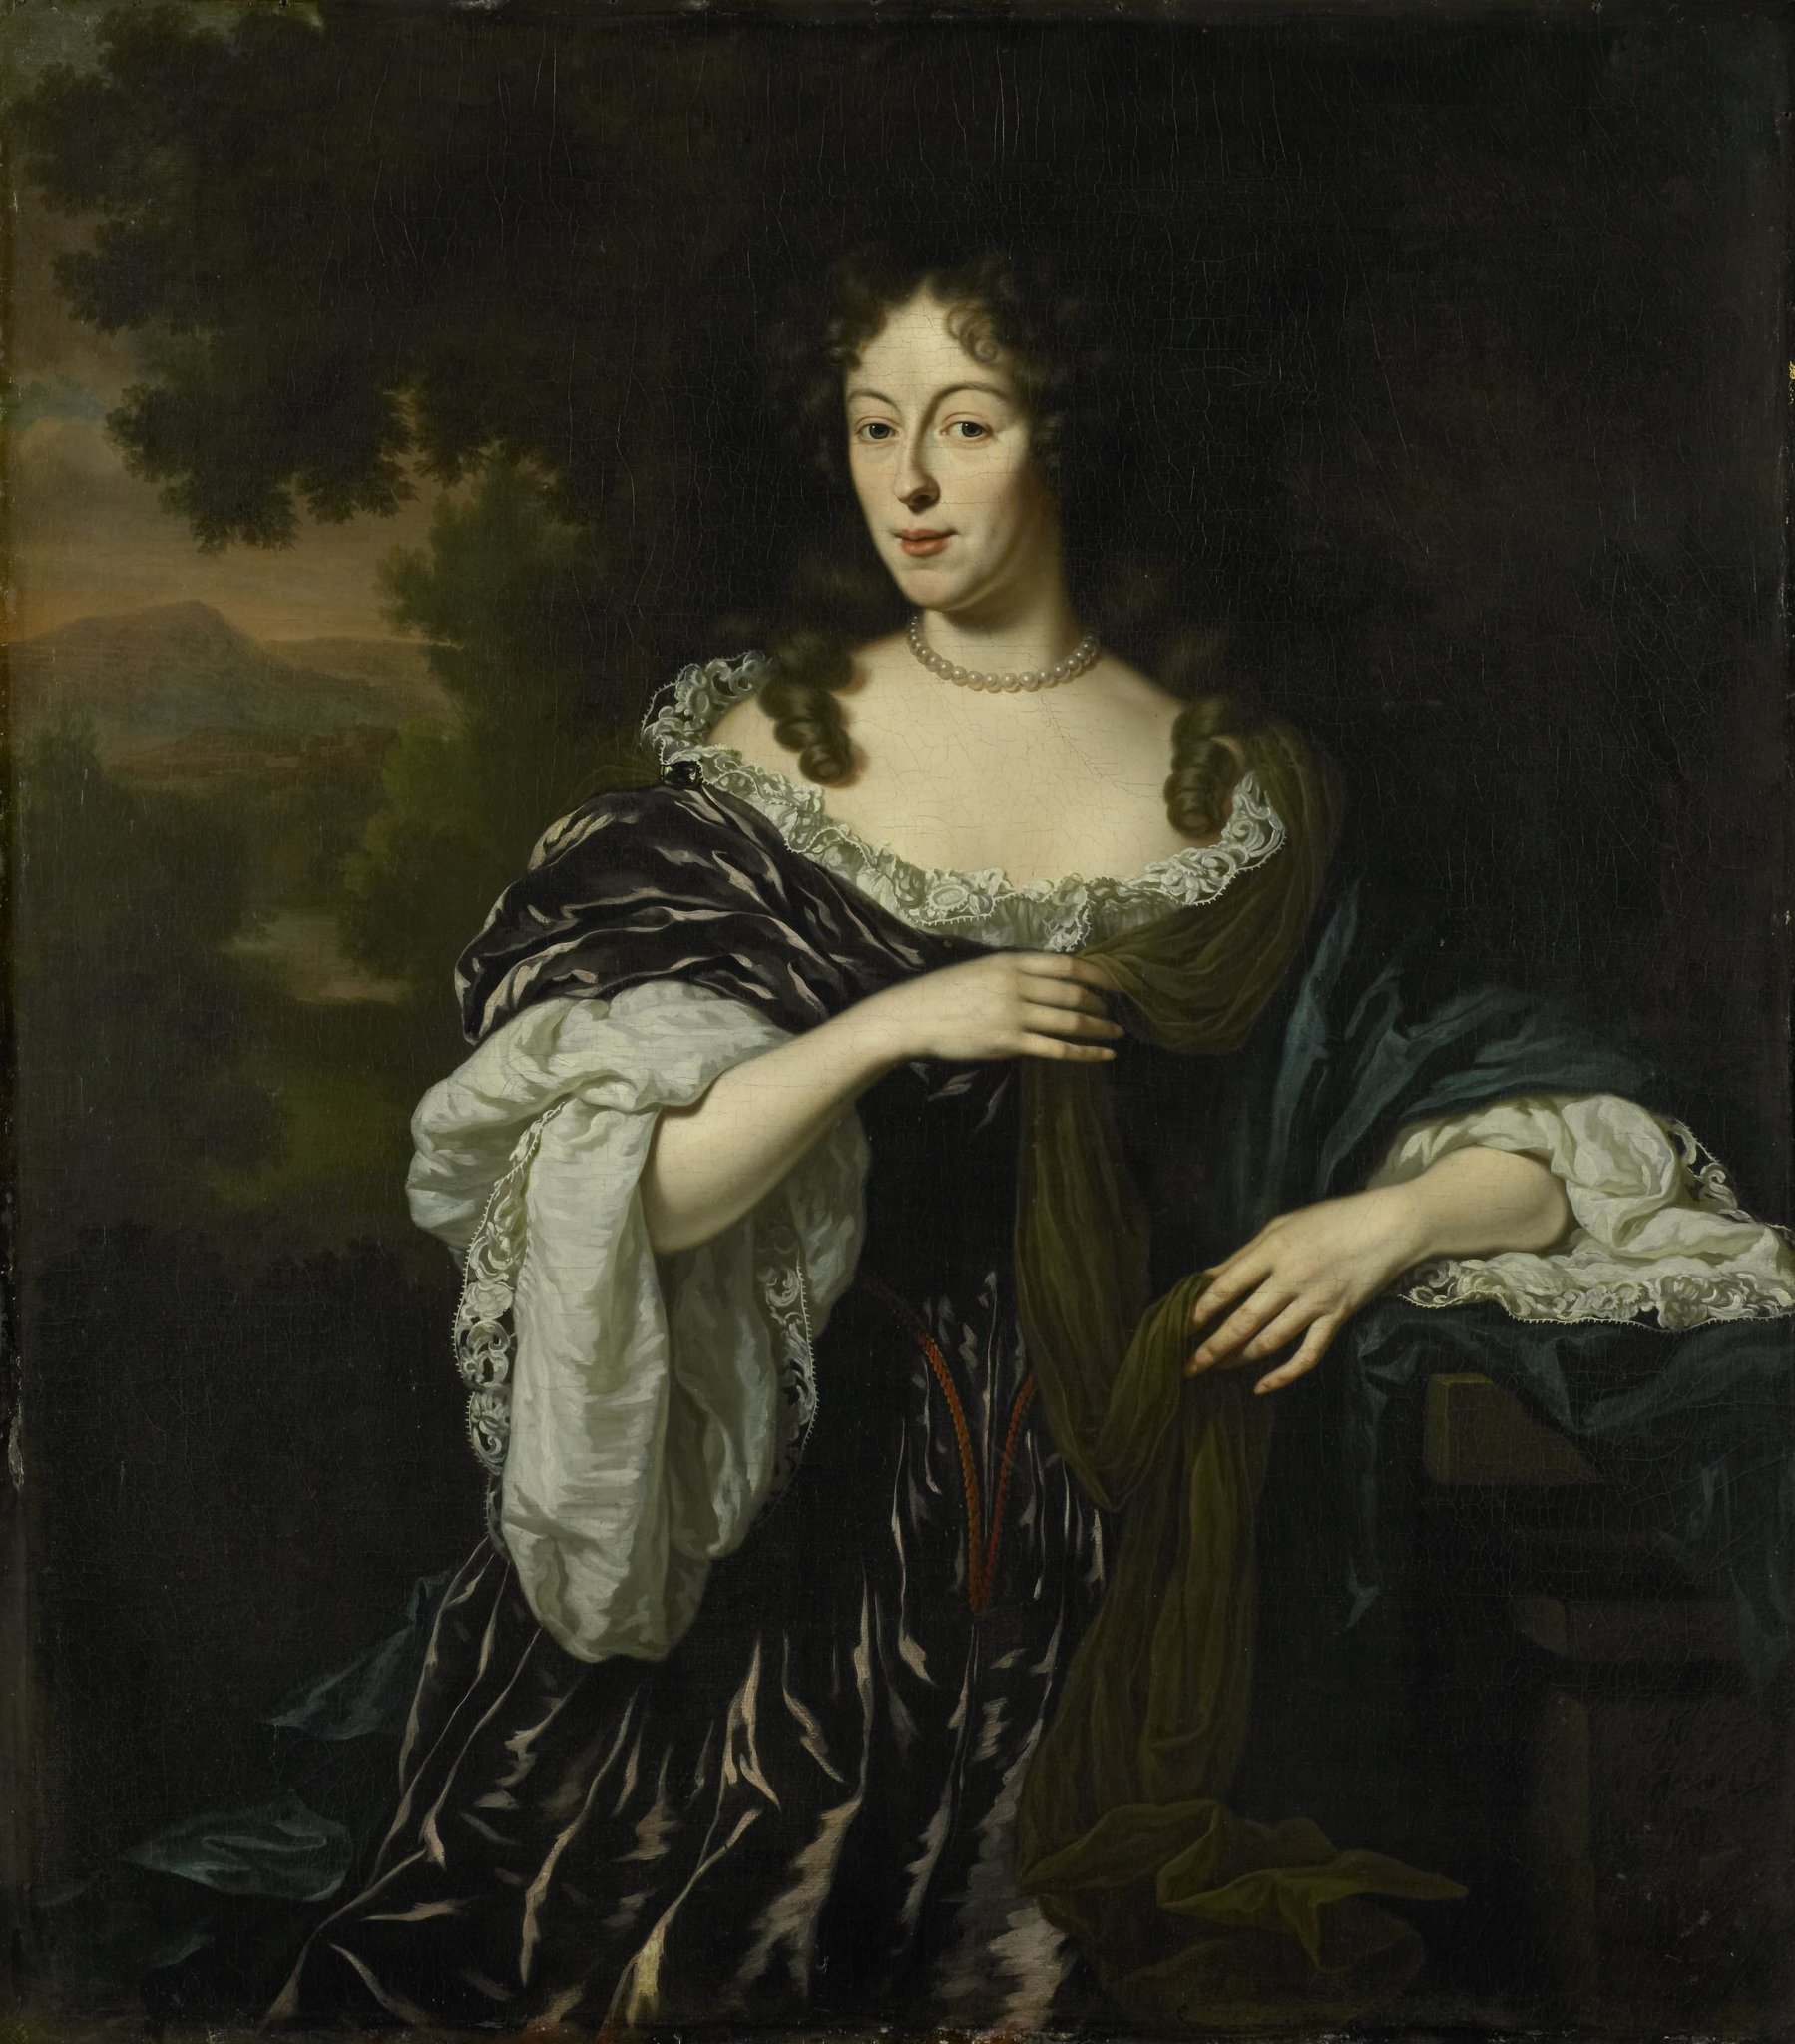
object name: painting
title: Portrait of Maria Schaep, Wife of Hendrick Bicker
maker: michiel van musscher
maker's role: draughtsman, painter, print maker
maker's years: 1645-1705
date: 1682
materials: canvas, oil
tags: mayor, historical persons - bb - woman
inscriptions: signature and date: ‘M.l v. Musscher Pinx.t Aº. 1682.’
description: Michiel van Musscher (1645 - 1705). Portrait of Maria Schaep (1658 - 1725). In original gilt frame with housekeeping attributes.